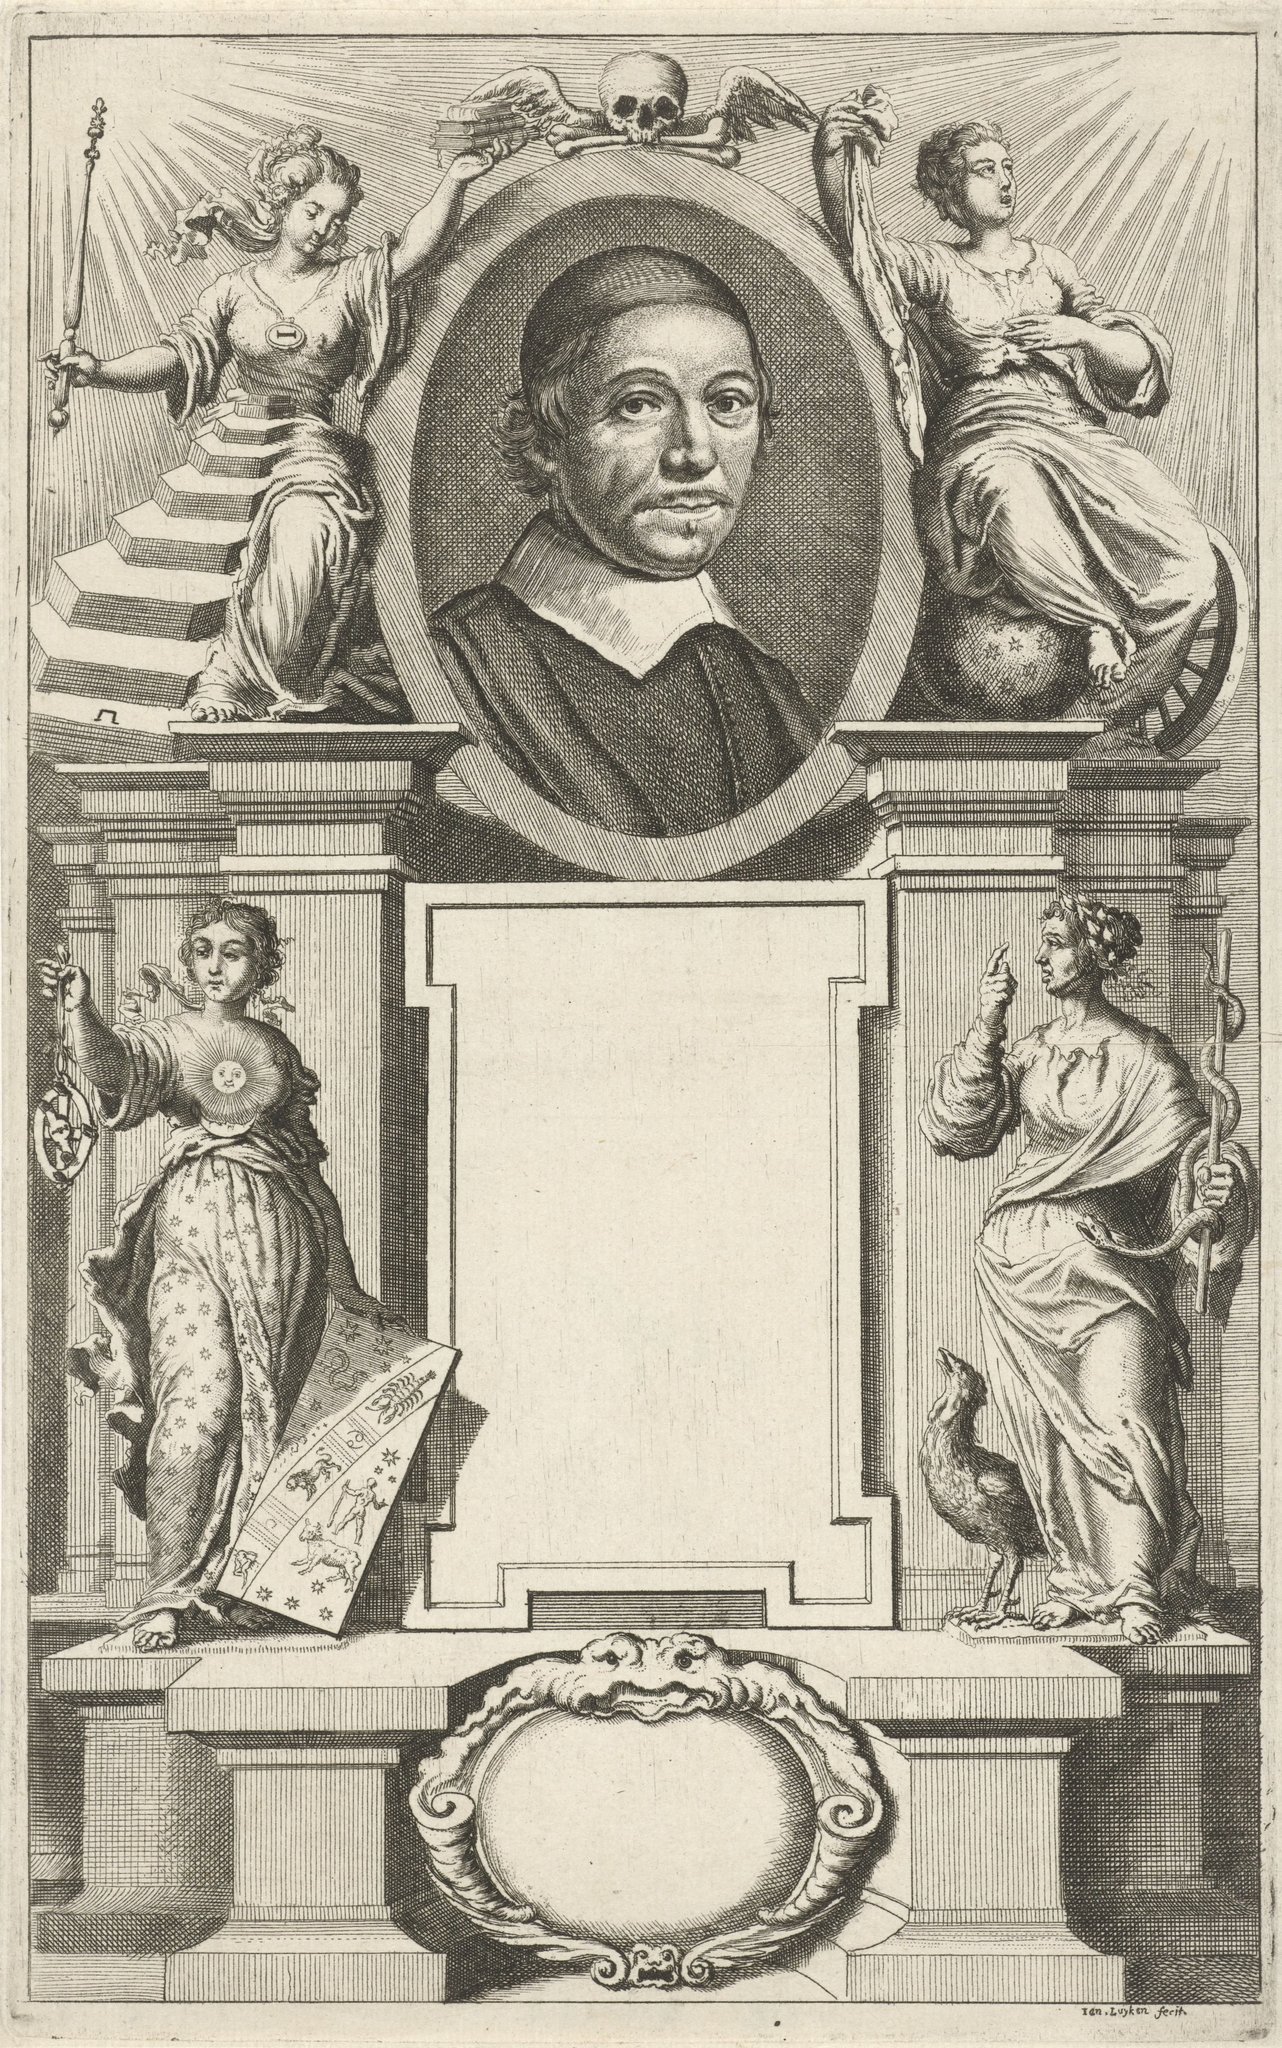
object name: print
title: Portret van Johannes de Mey, geflankeerd door Wijsbegeerte en Godgeleerdheid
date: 1681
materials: paper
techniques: etching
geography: middelburg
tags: middelburg, 'astronomia', 'cosmografia'; 'cosmografia' (ripa), portrait of a writer, 'philosophia'; 'filosofia' (ripa), theology; 'theologia' (ripa), 'medicina', allegorical representations ~ medicine; 'medicina' (ripa)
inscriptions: collector's mark: Lugt 2228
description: Portret van de theoloog Johannes de Mey, geflankeerd door de personificaties van wijsbegeerte (links) en godgeleerdheid (rechts). Onder het portret staan de gepersonifieerde sterrenkunde (links) en geneeskunde (rechts).